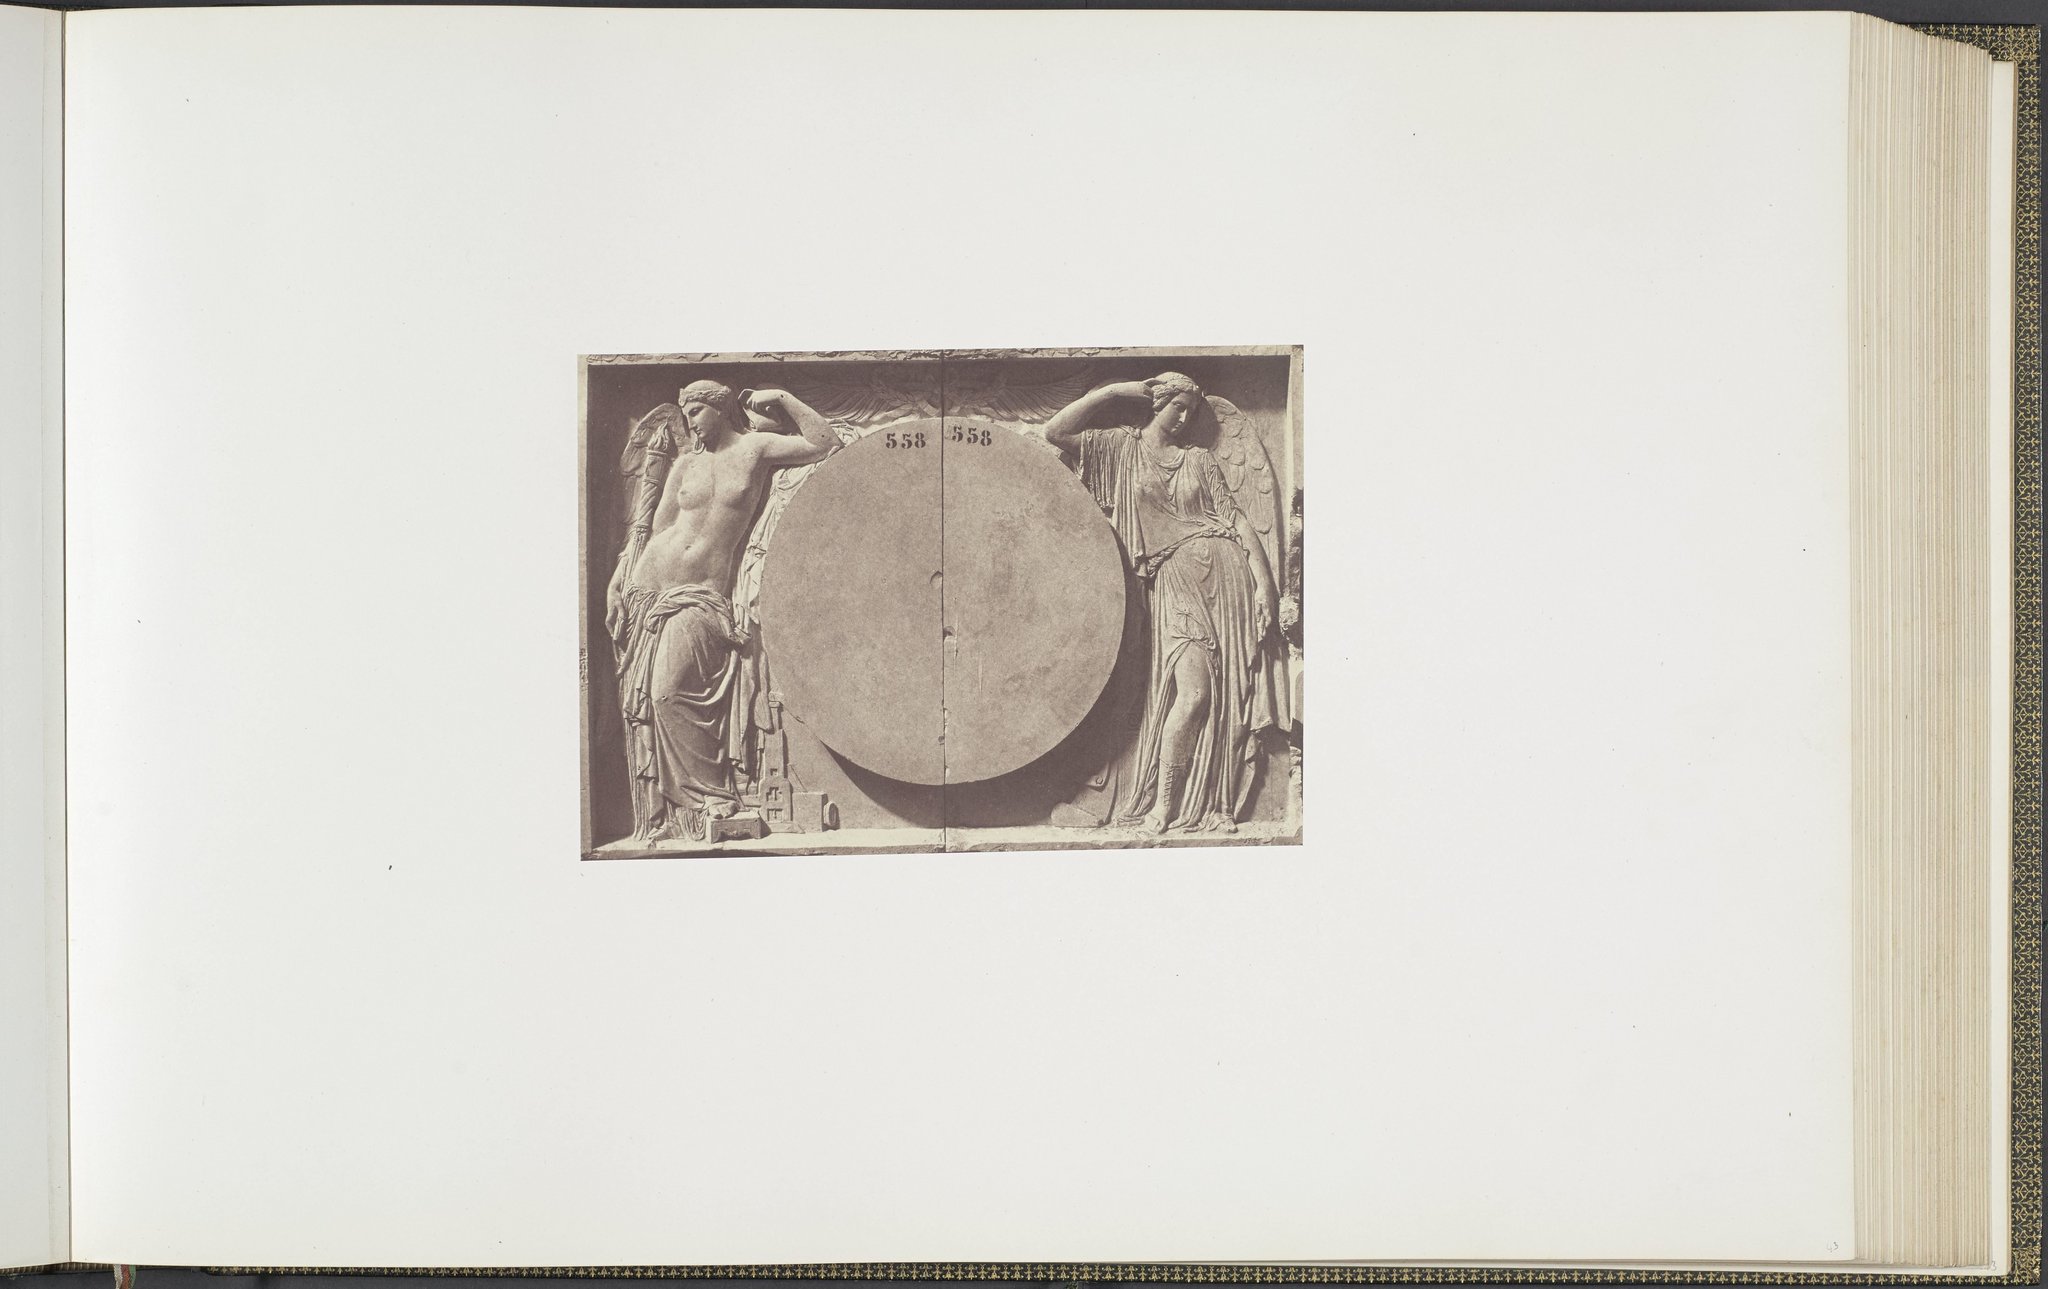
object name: photograph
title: Gipsmodel voor beeldhouwwerk op het Palais du Louvre: "L'Invention et la Réflexion" door Georges Diébolt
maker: édouard denis baldus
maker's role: fotograaf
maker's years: 1813-1889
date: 1855-1857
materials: paper, photographic support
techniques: salted paper print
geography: paris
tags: piece of sculpture, reproduction of a piece of sculpture, permanent exhibition, museum, paris, tuileries palace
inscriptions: number: ‘558’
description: Onderdeel van Réunion des Tuileries au Louvre 1852-1857, album 1.